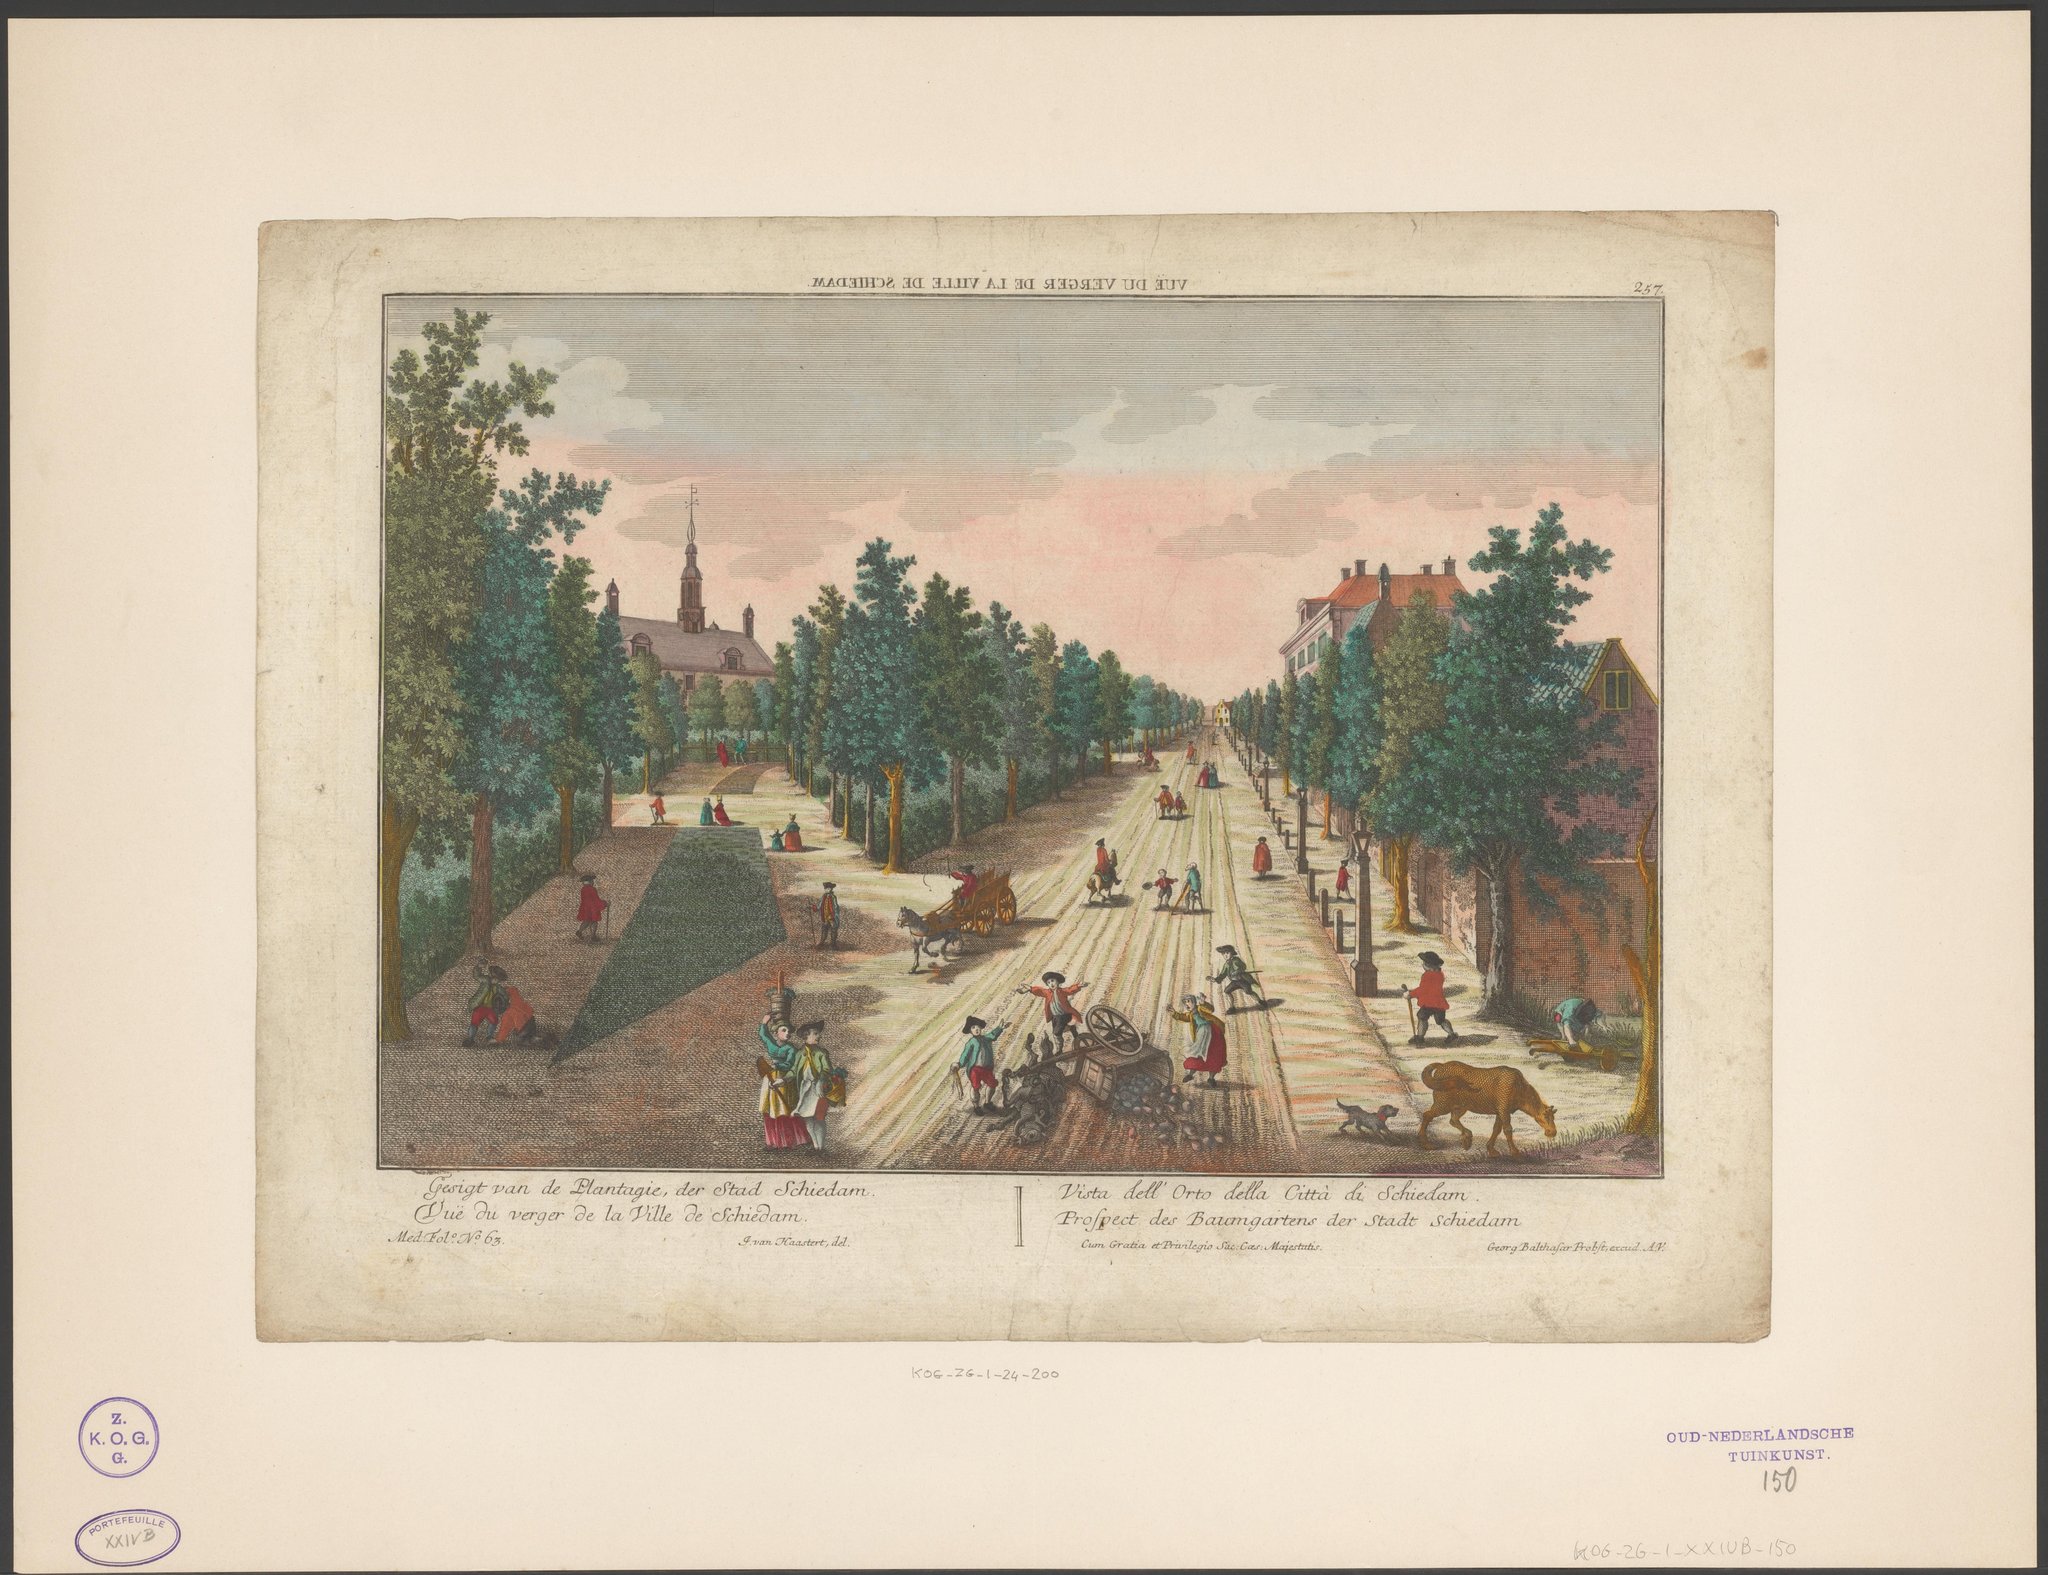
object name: print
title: Vuë du Verger de la Ville de Schiedam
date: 1742-1801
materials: paper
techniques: etching, hand coloring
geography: augsburg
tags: public gardens, park (+ city(-scape) with figures, staffage), townhall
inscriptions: collector's mark: Lugt 1641, stamp, stamp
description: Op de voorgrond een verongelukte ezelkar met appels. Op de achtergrond links het Stadhuis. Rechtsboven genummerd: 257. Linksonder genummerd: 63. Onderwerpsrubrieken binnen de Atlas Zeden en Gewoonten: Zeden en Gewoonten in Engeren Zin, De Woning, Oude Nederlandsche Tuinkunst. De 18de eeuw. Stadsbeplanting.